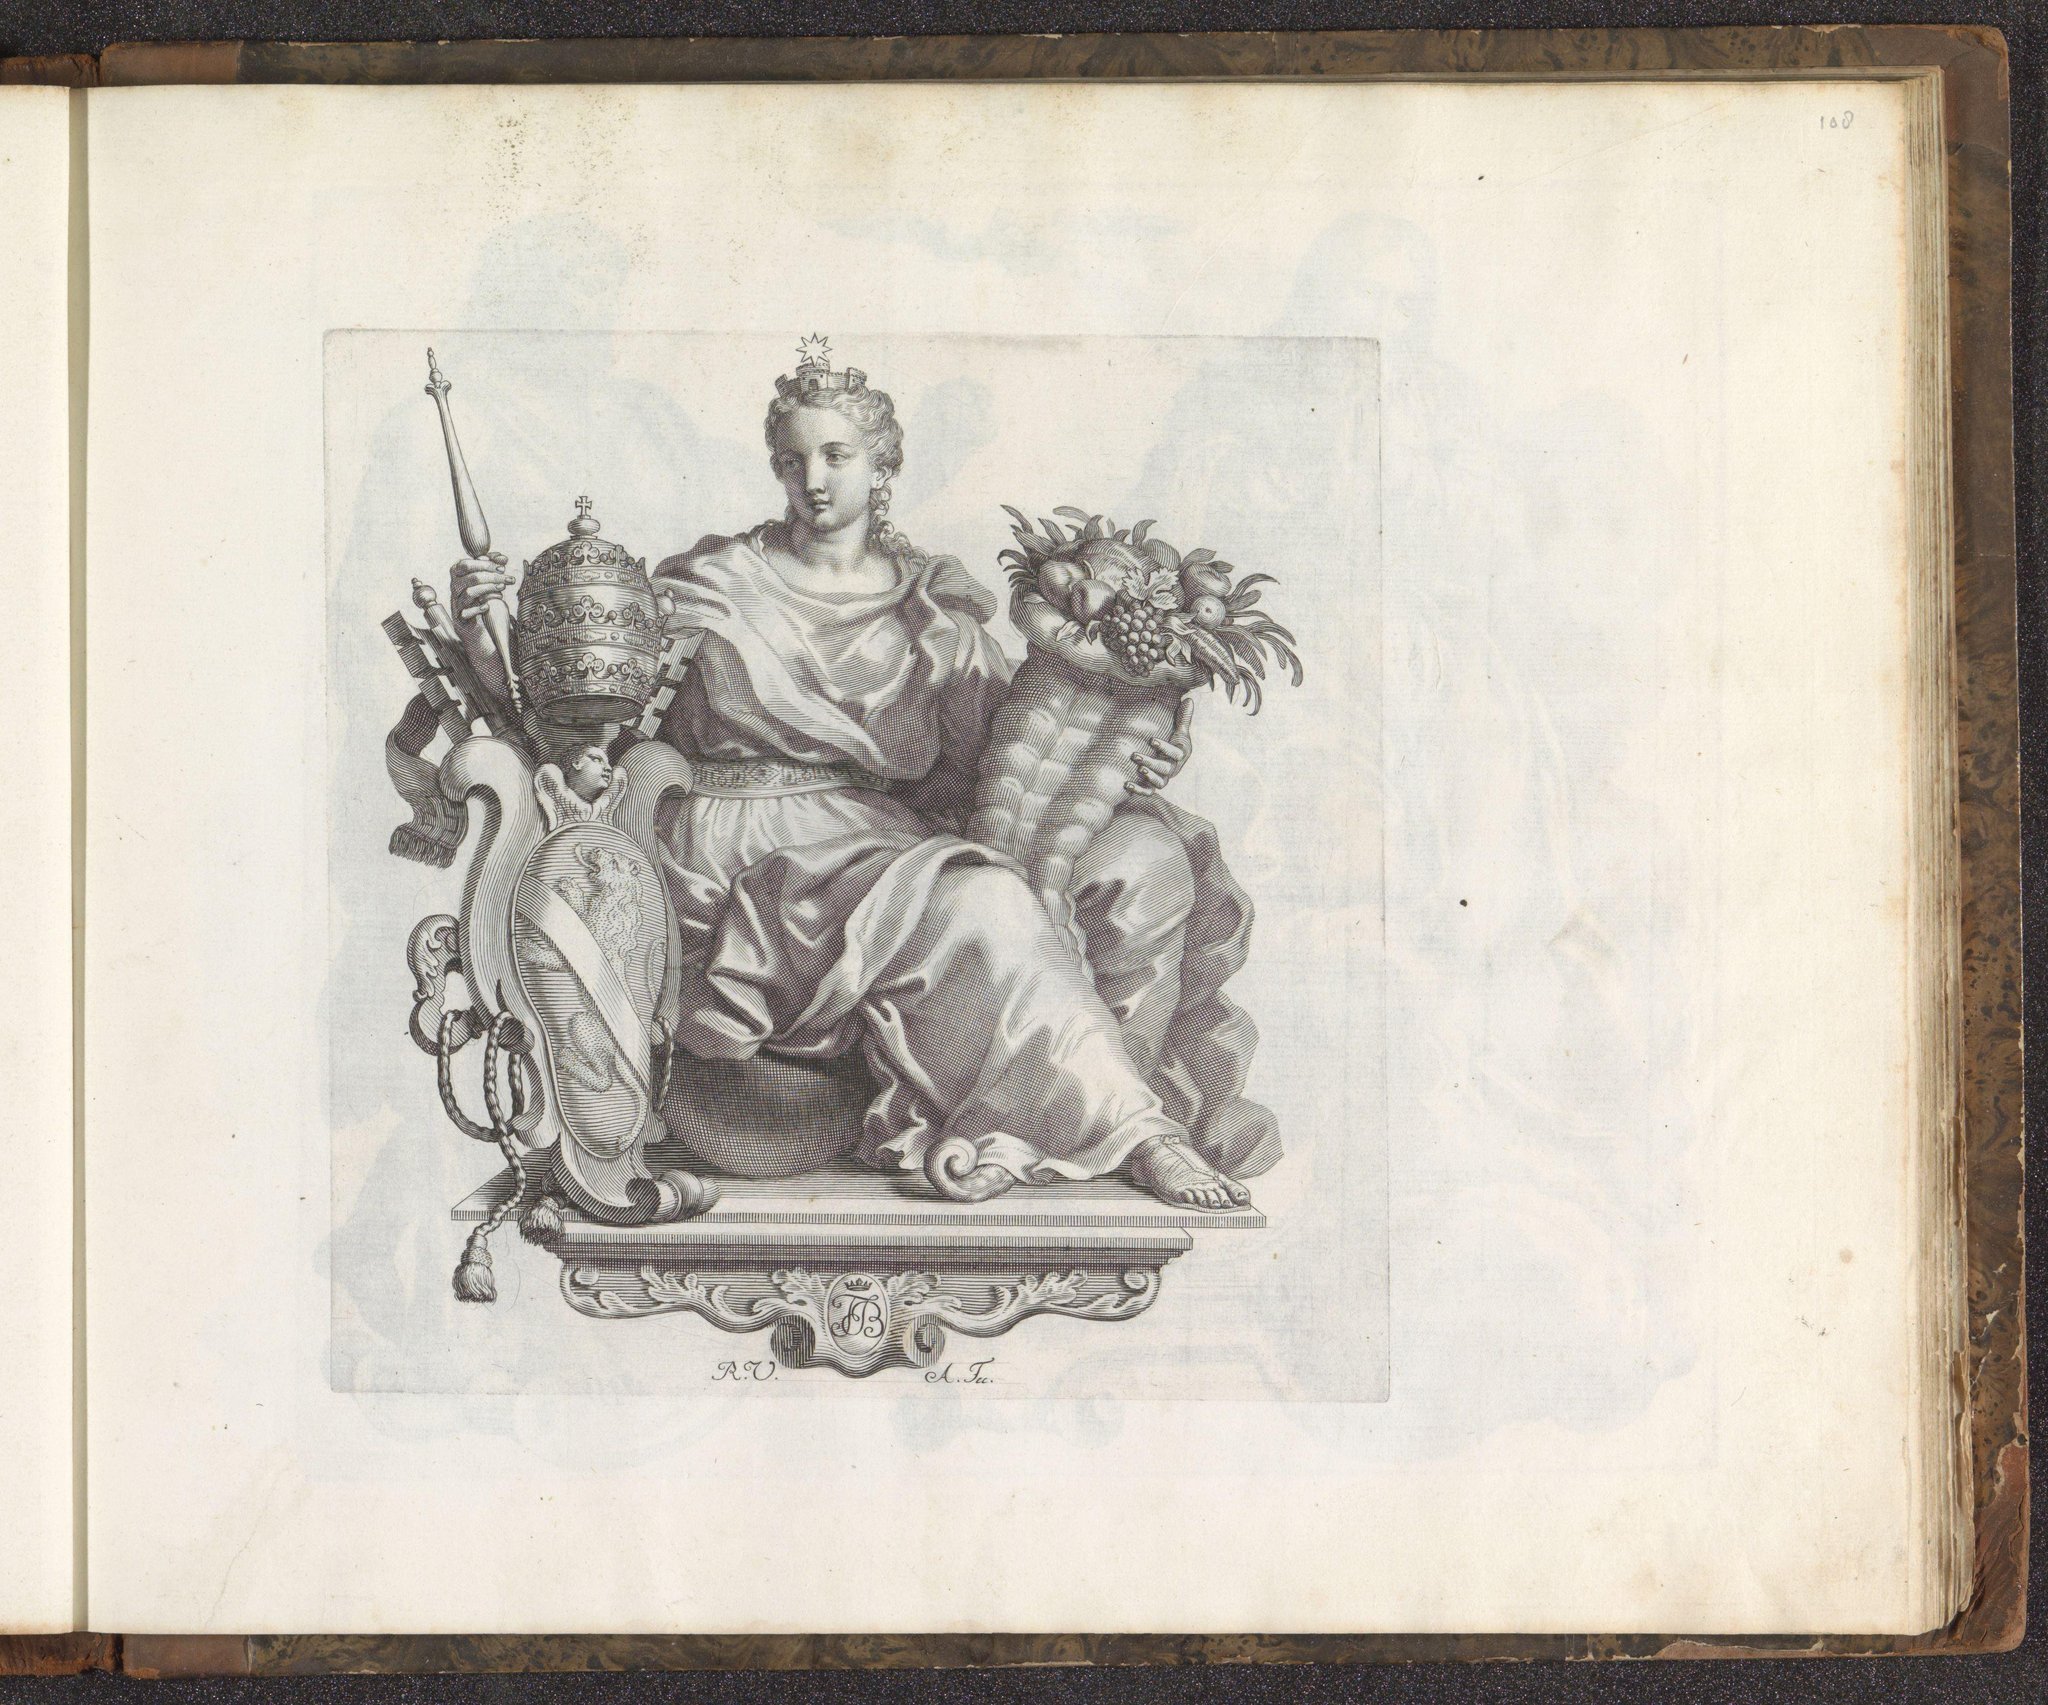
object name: album leaf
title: Personificatie van Italië met het wapen van de paus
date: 1673-1743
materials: paper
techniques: engraving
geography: rome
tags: 'cornucopia', horn of plenty, personifications of countries, nations, states, districts, etc., insignia of the pope, e.g. tiara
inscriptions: collector's mark: Lugt 2228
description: Een console met een de vrouwelijke personificatie van Italië. Ze zit op een aardbol en heeft torens met een ster op haar hoofd. In haar rechterhand heeft ze een scepter en in haar linkerhand een hoorn des overvloeds. Links het wapenschild van de paus Sixtus V of paus Paulus II. De prent maakt deel uit van een album.